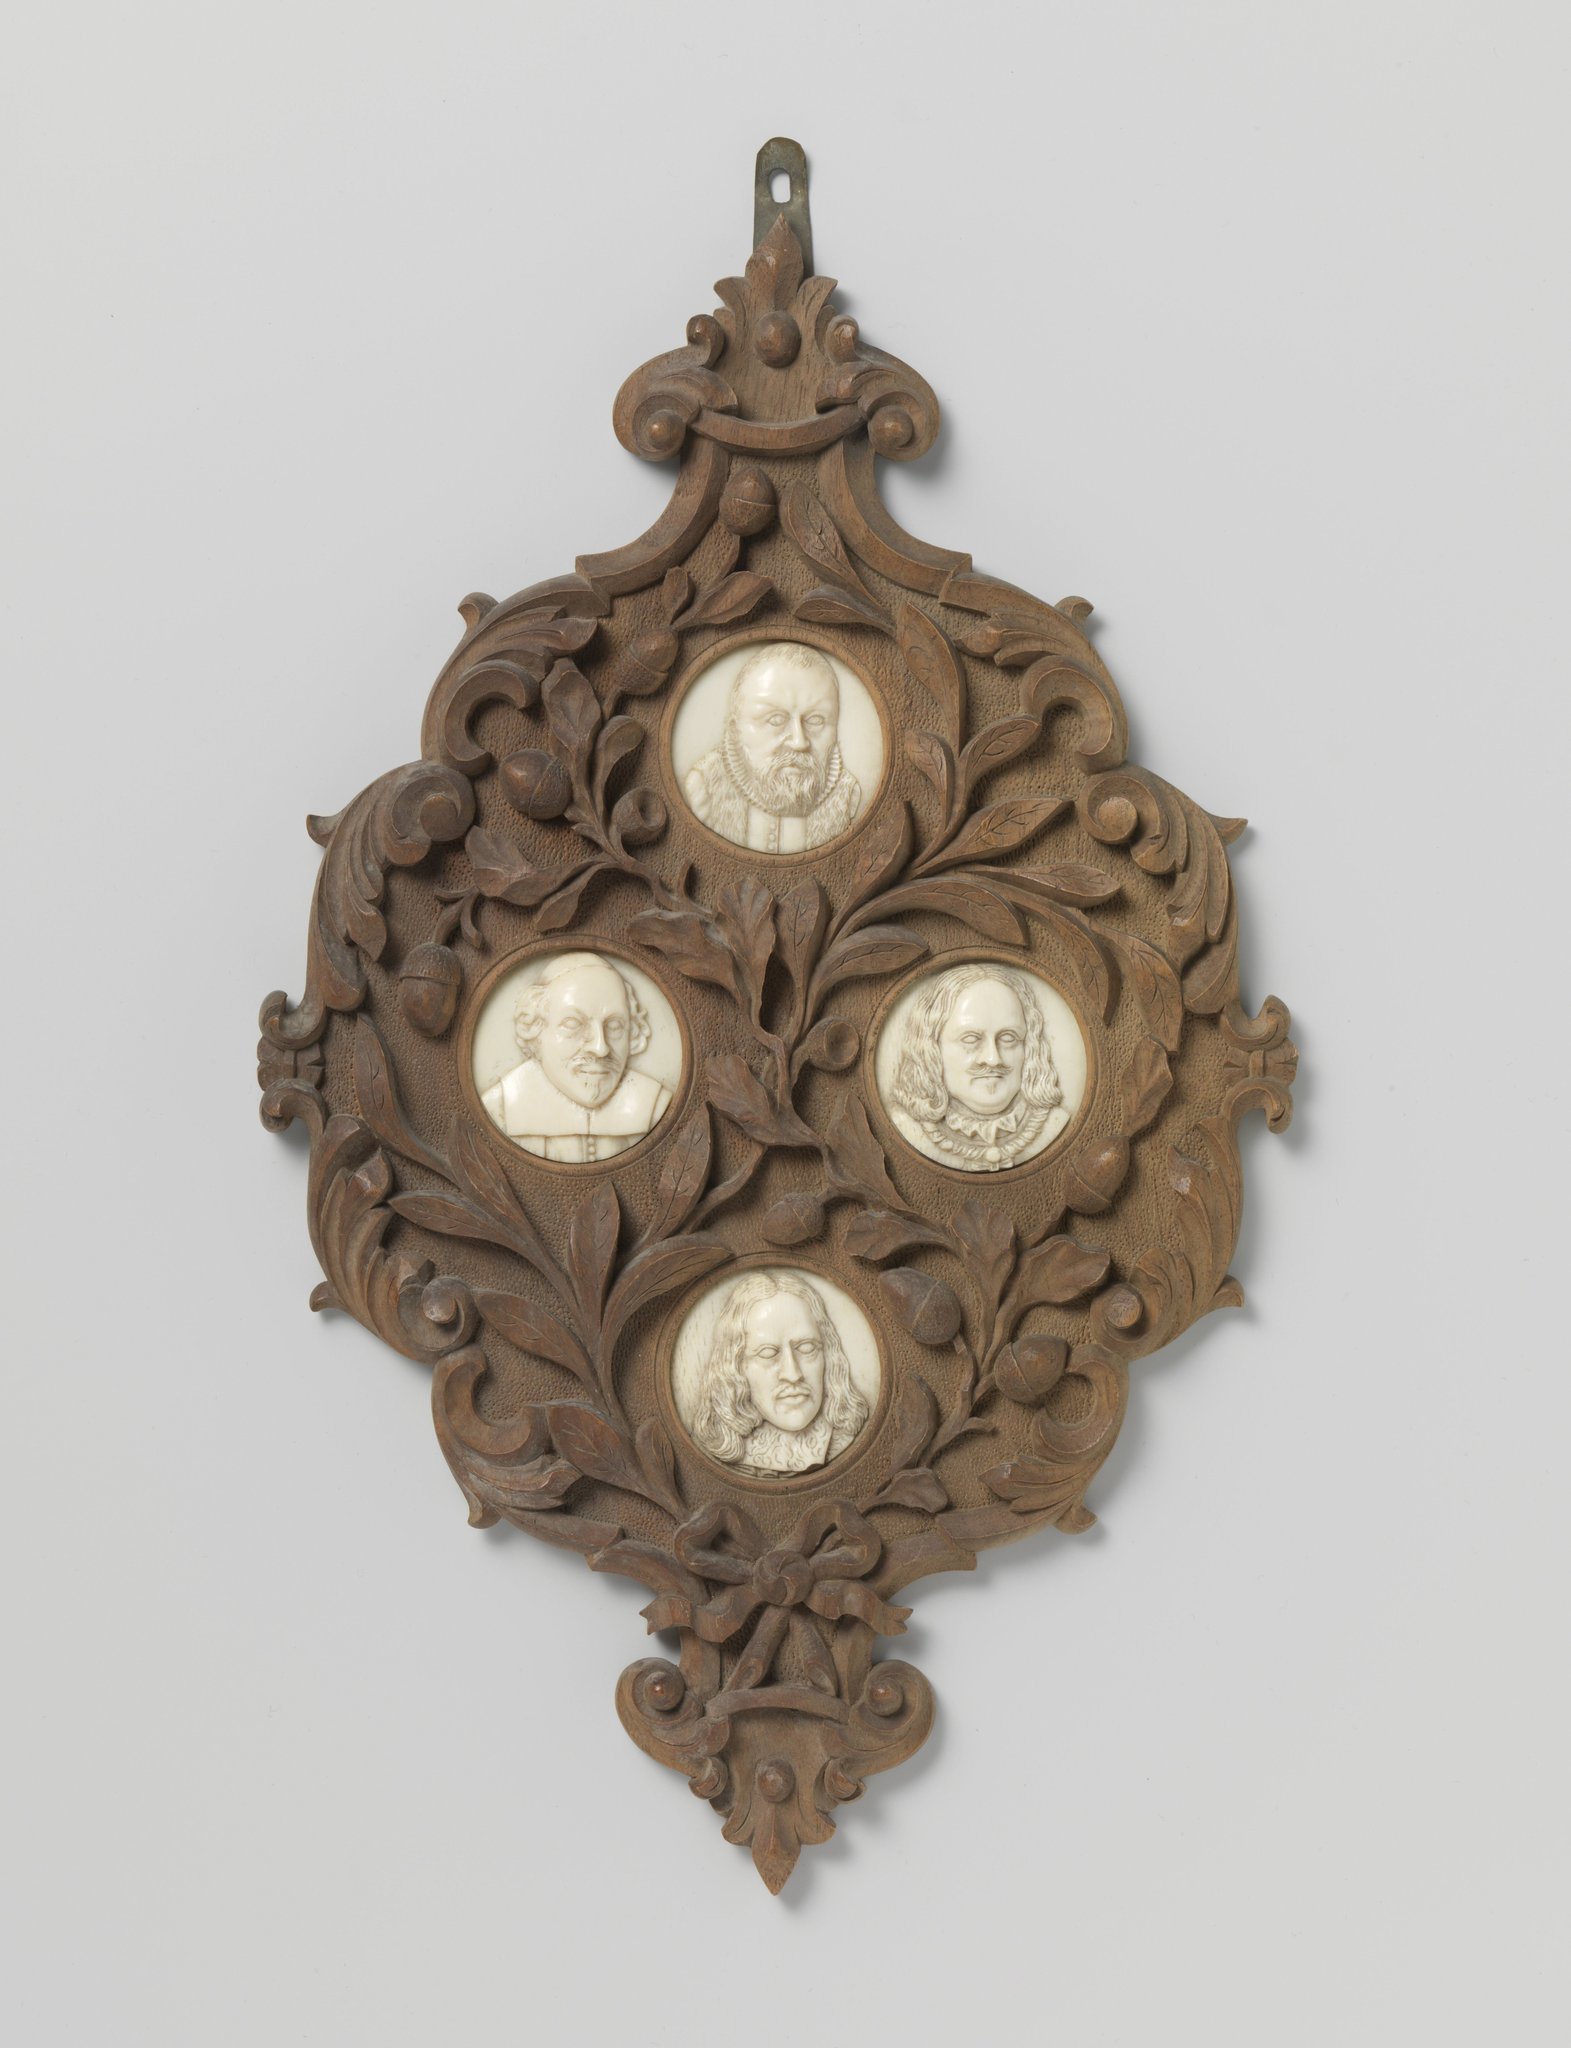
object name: sculpture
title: Frame with Four Portrait Medallions, Representing Johan van Oldenbarnevelt (1547-1619), Joost van den Vondel (1587-1679), Michiel Adriaensz de Ruyter (1607-1676) and Johan de Witt (1625-1672)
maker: Anonymous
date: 1850-1875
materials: ivory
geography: netherlands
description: Vier portretjes naar rechts, gevat in één lijst met eikeloof in reliëf op geponste grond en met een rand van voluutvormige ranken en cartouchevormige uiteinden boven en onder. 1. Johan van Oldenbarnevelt (1547-1619), Nederlandse staatsman. In de achterkant gegraveerd 'Wie ging zo kromgebukt noit krom!' 2. Joost van den Vondel (1587-1679), Nederlands dichter. In de achterkant gegraveerd 'Lees Vondel duizend maal, gij leest hem telkens 't eerst!' 3. Michiel Adraensz. de Ruyter (1607-1676), Nederlands admiraal. In de achterkant gegraveerd 'Hij blinkt in onbezoedelde eere' 4. Johan de Witt (1625-1672), Nederlands staatsman. In de achterkant gegraveerd 'Prospera omnes sibi vindicant adversa uni imputantur'